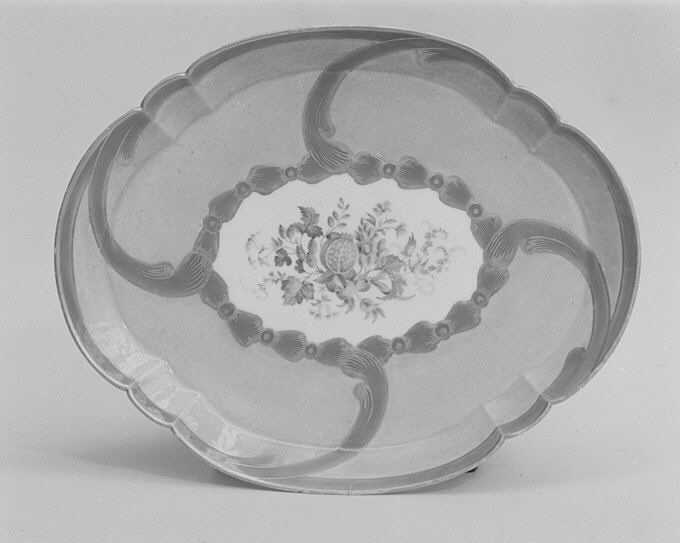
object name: tray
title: Tray (part of a service)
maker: sèvres manufactory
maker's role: manufactory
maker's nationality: french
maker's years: 1740-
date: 1759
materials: soft paste porcelain